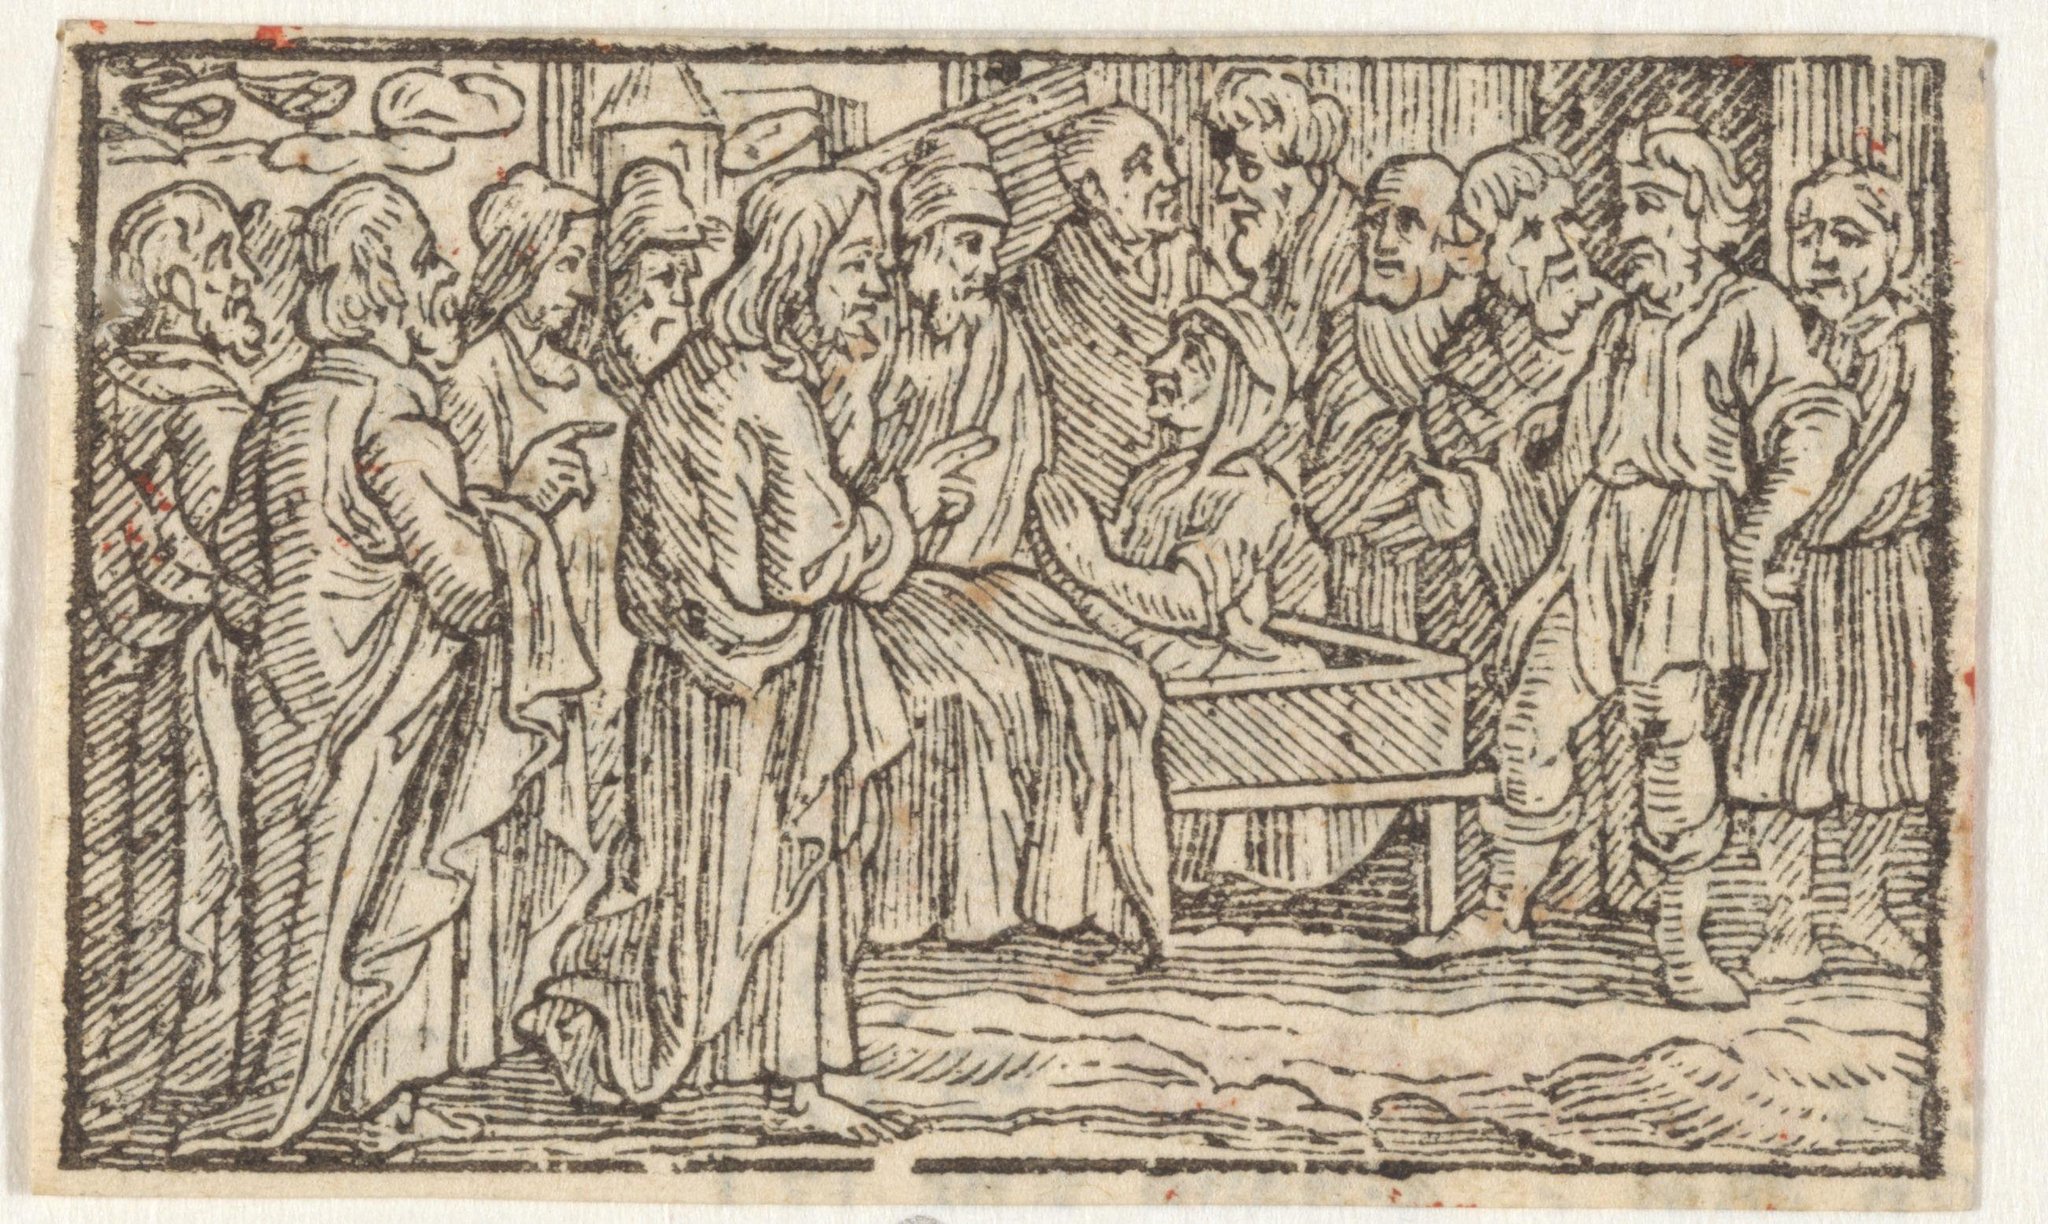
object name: book illustration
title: Christus geneest een zieke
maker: Anonymous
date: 1600-1699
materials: paper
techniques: letterpress printing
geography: netherlands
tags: miracles of christ ~ healing the sick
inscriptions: collector's mark: Lugt 240